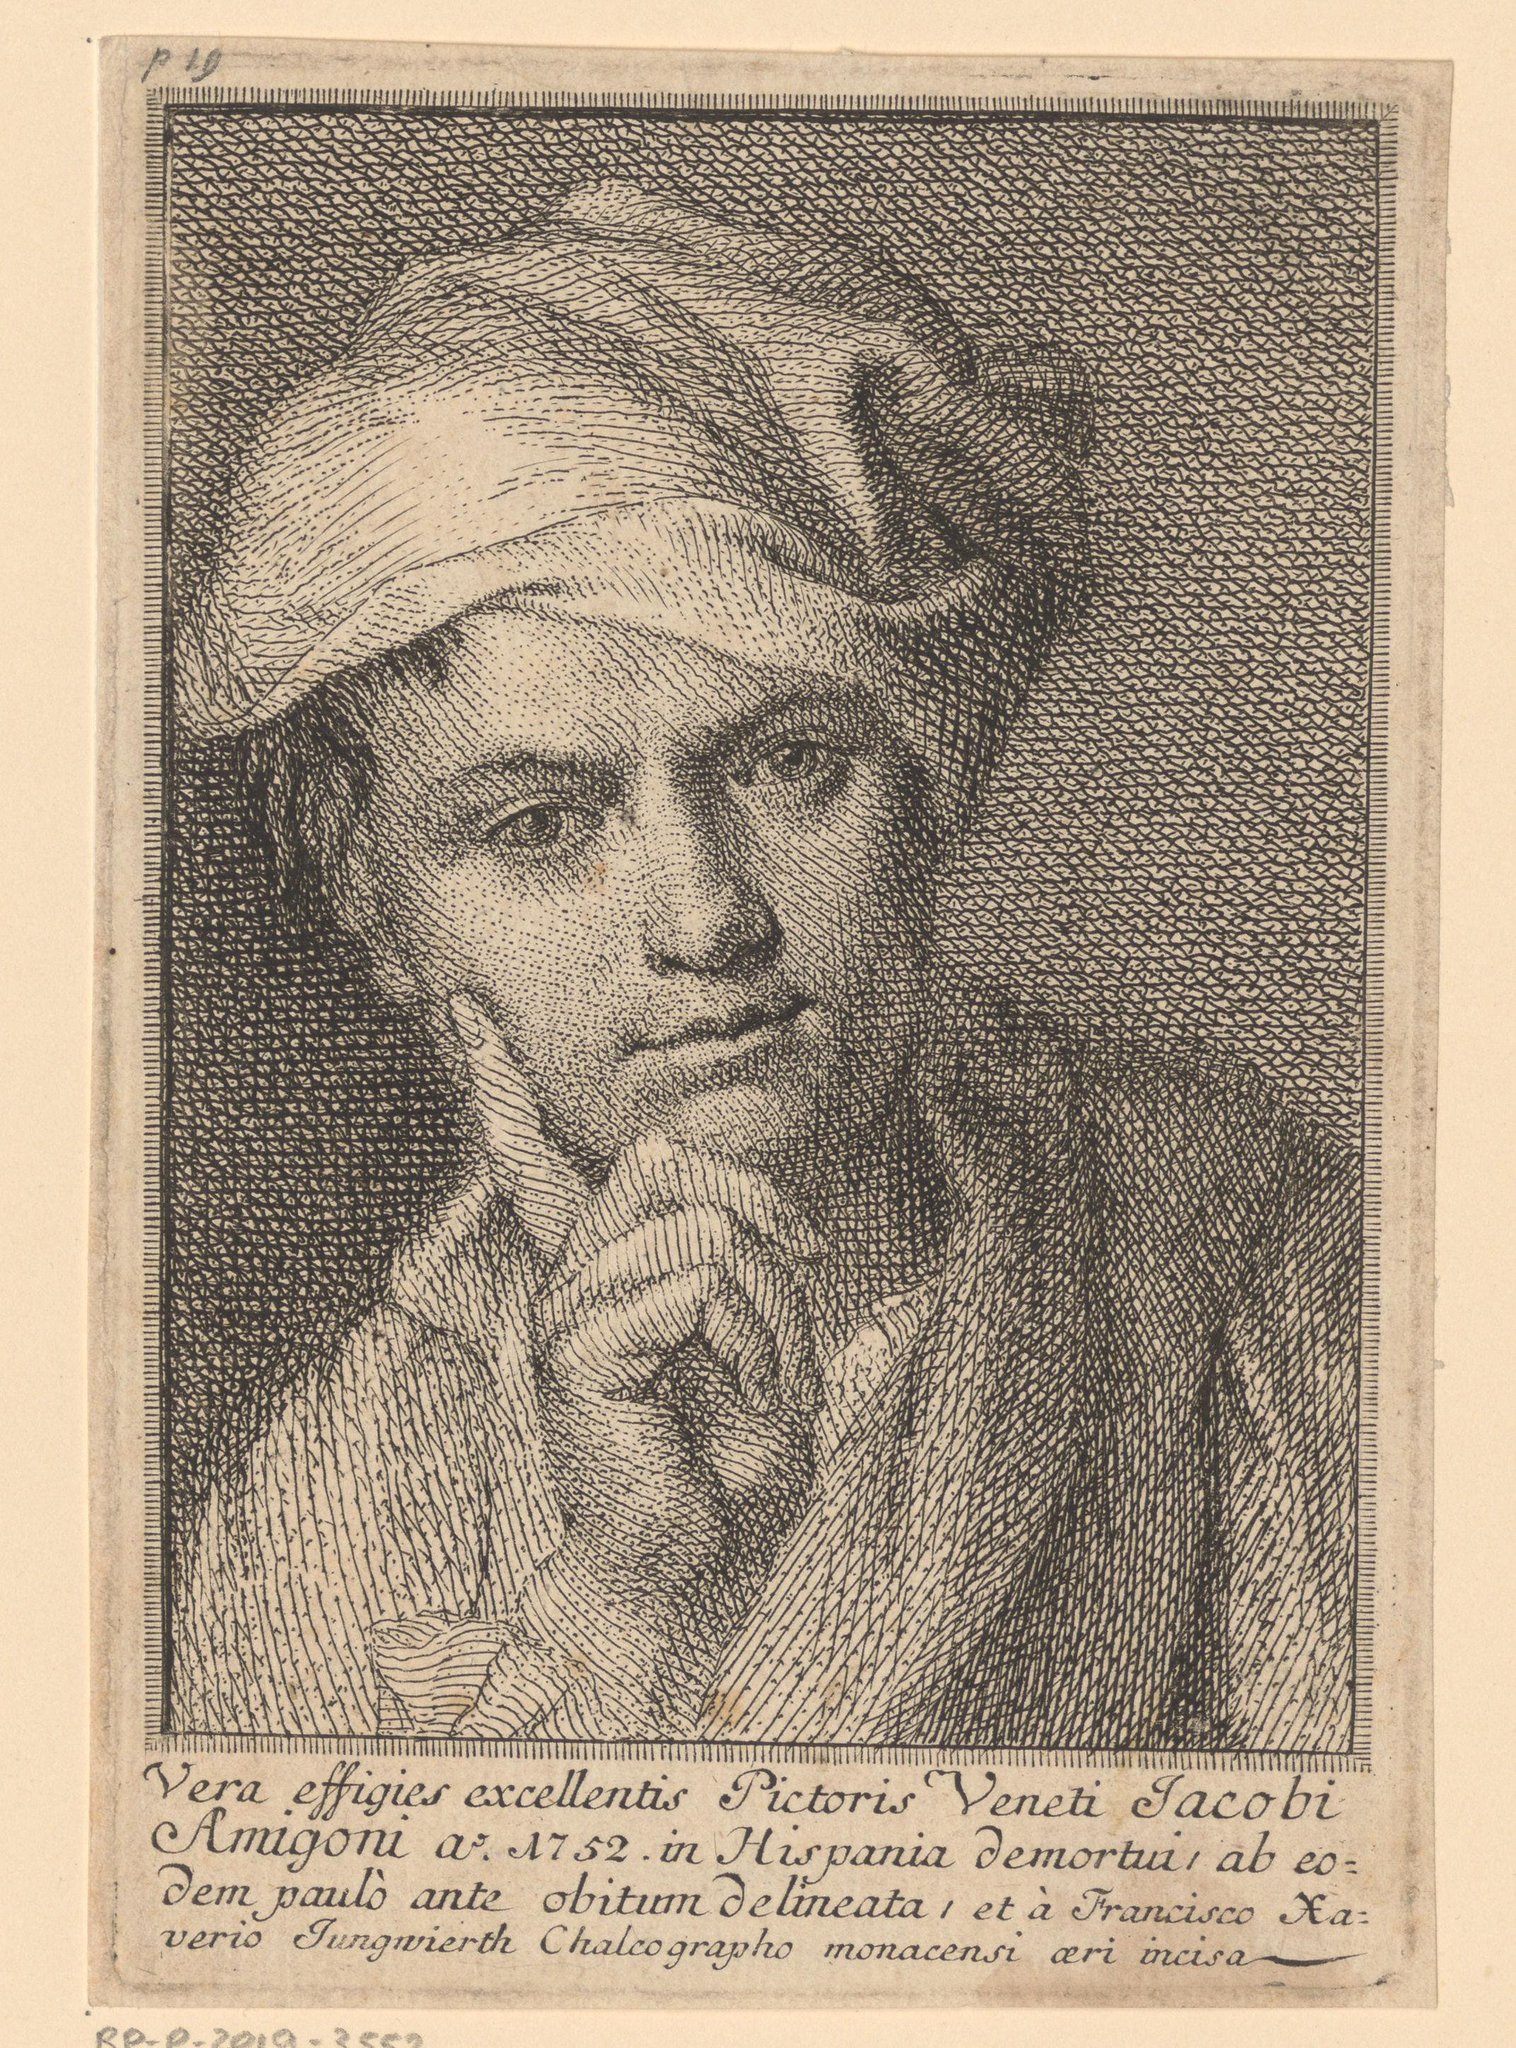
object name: print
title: Portret van Jacopo Amigoni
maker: franz xaver jungwirth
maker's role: print maker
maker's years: 1720-1790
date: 1752-1790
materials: paper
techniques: etching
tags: painter, print maker, designer, jacopo amigoni, historical persons, portrait, self-portrait of painter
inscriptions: inscription: ‘p. 19’